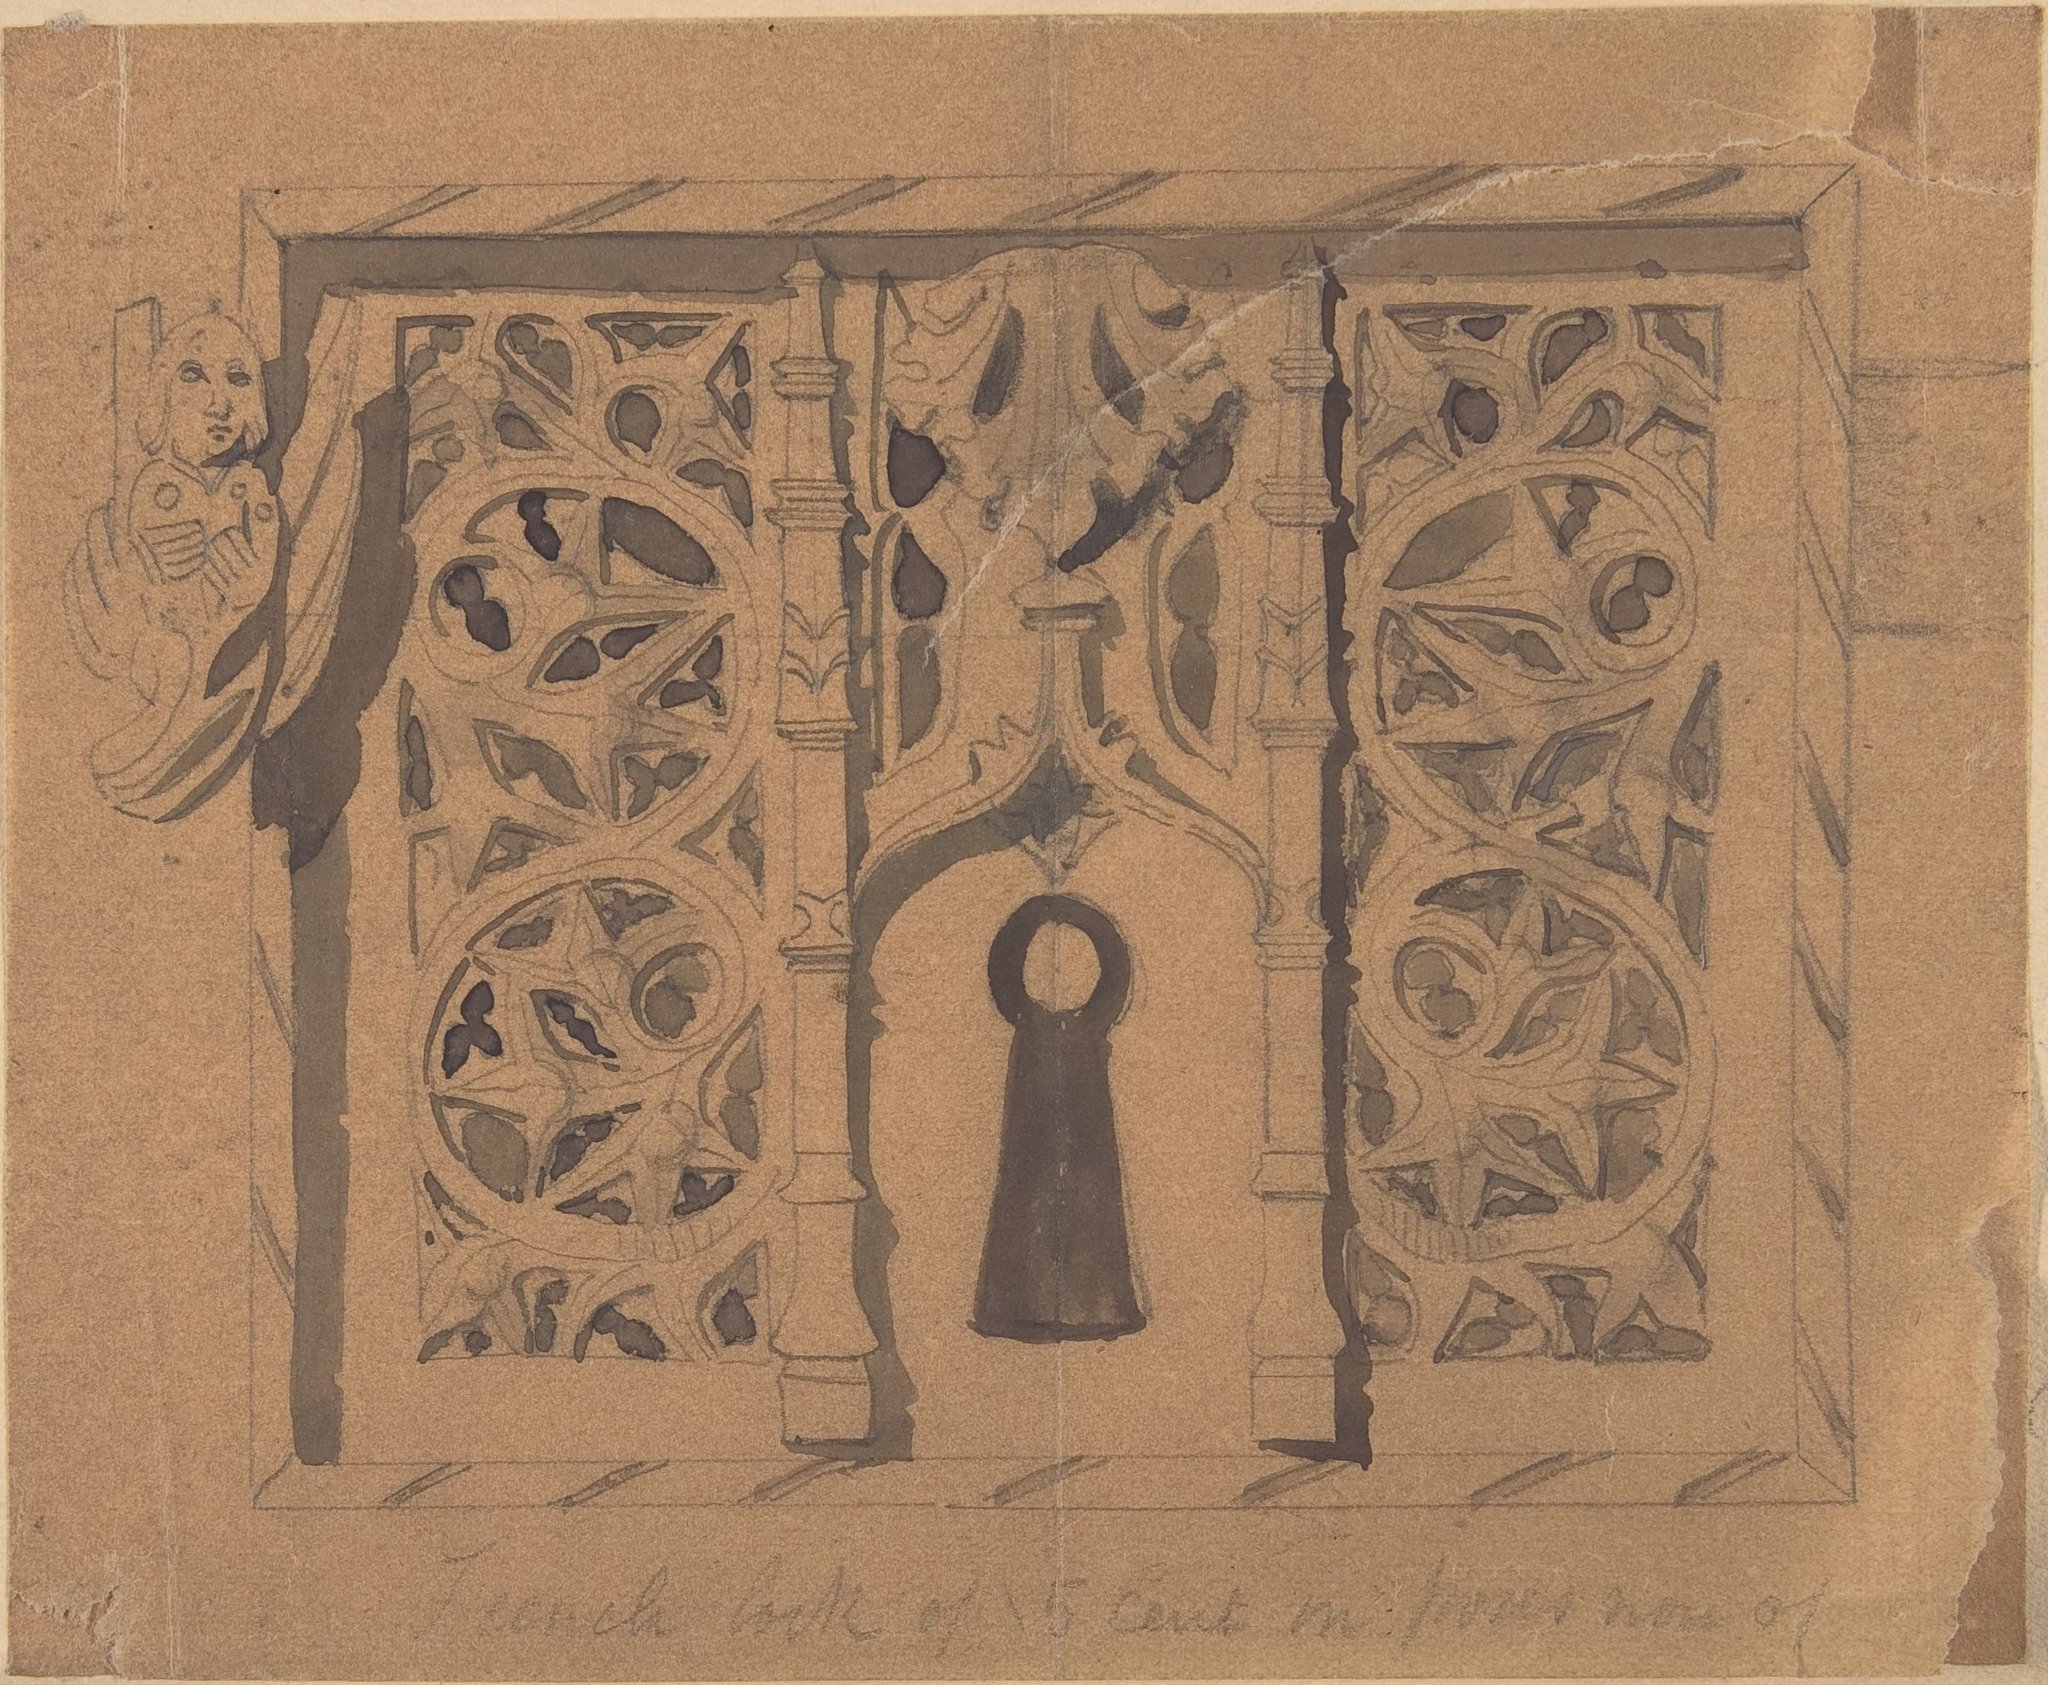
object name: drawing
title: Ornament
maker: richardson ellson & co.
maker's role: artist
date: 1880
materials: graphite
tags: ornament,faces